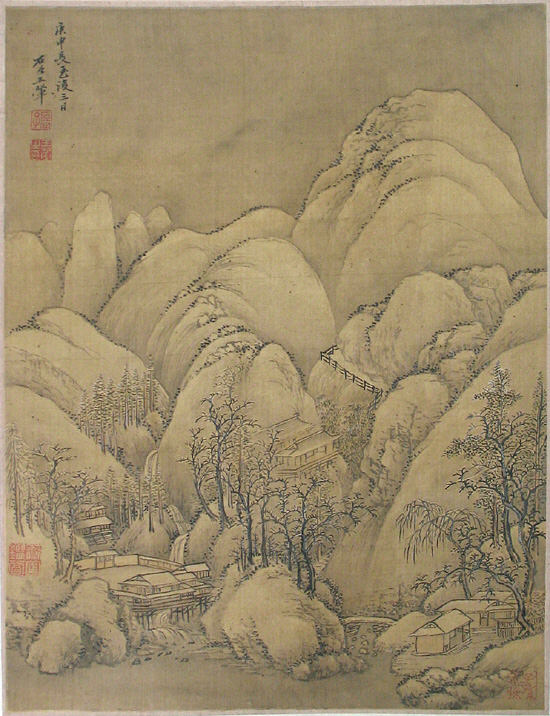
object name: hanging scroll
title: Landscape after Li Cheng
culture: chinese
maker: unidentified artist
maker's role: artist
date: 1701-1800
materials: ink, silk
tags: mountains,landscapes